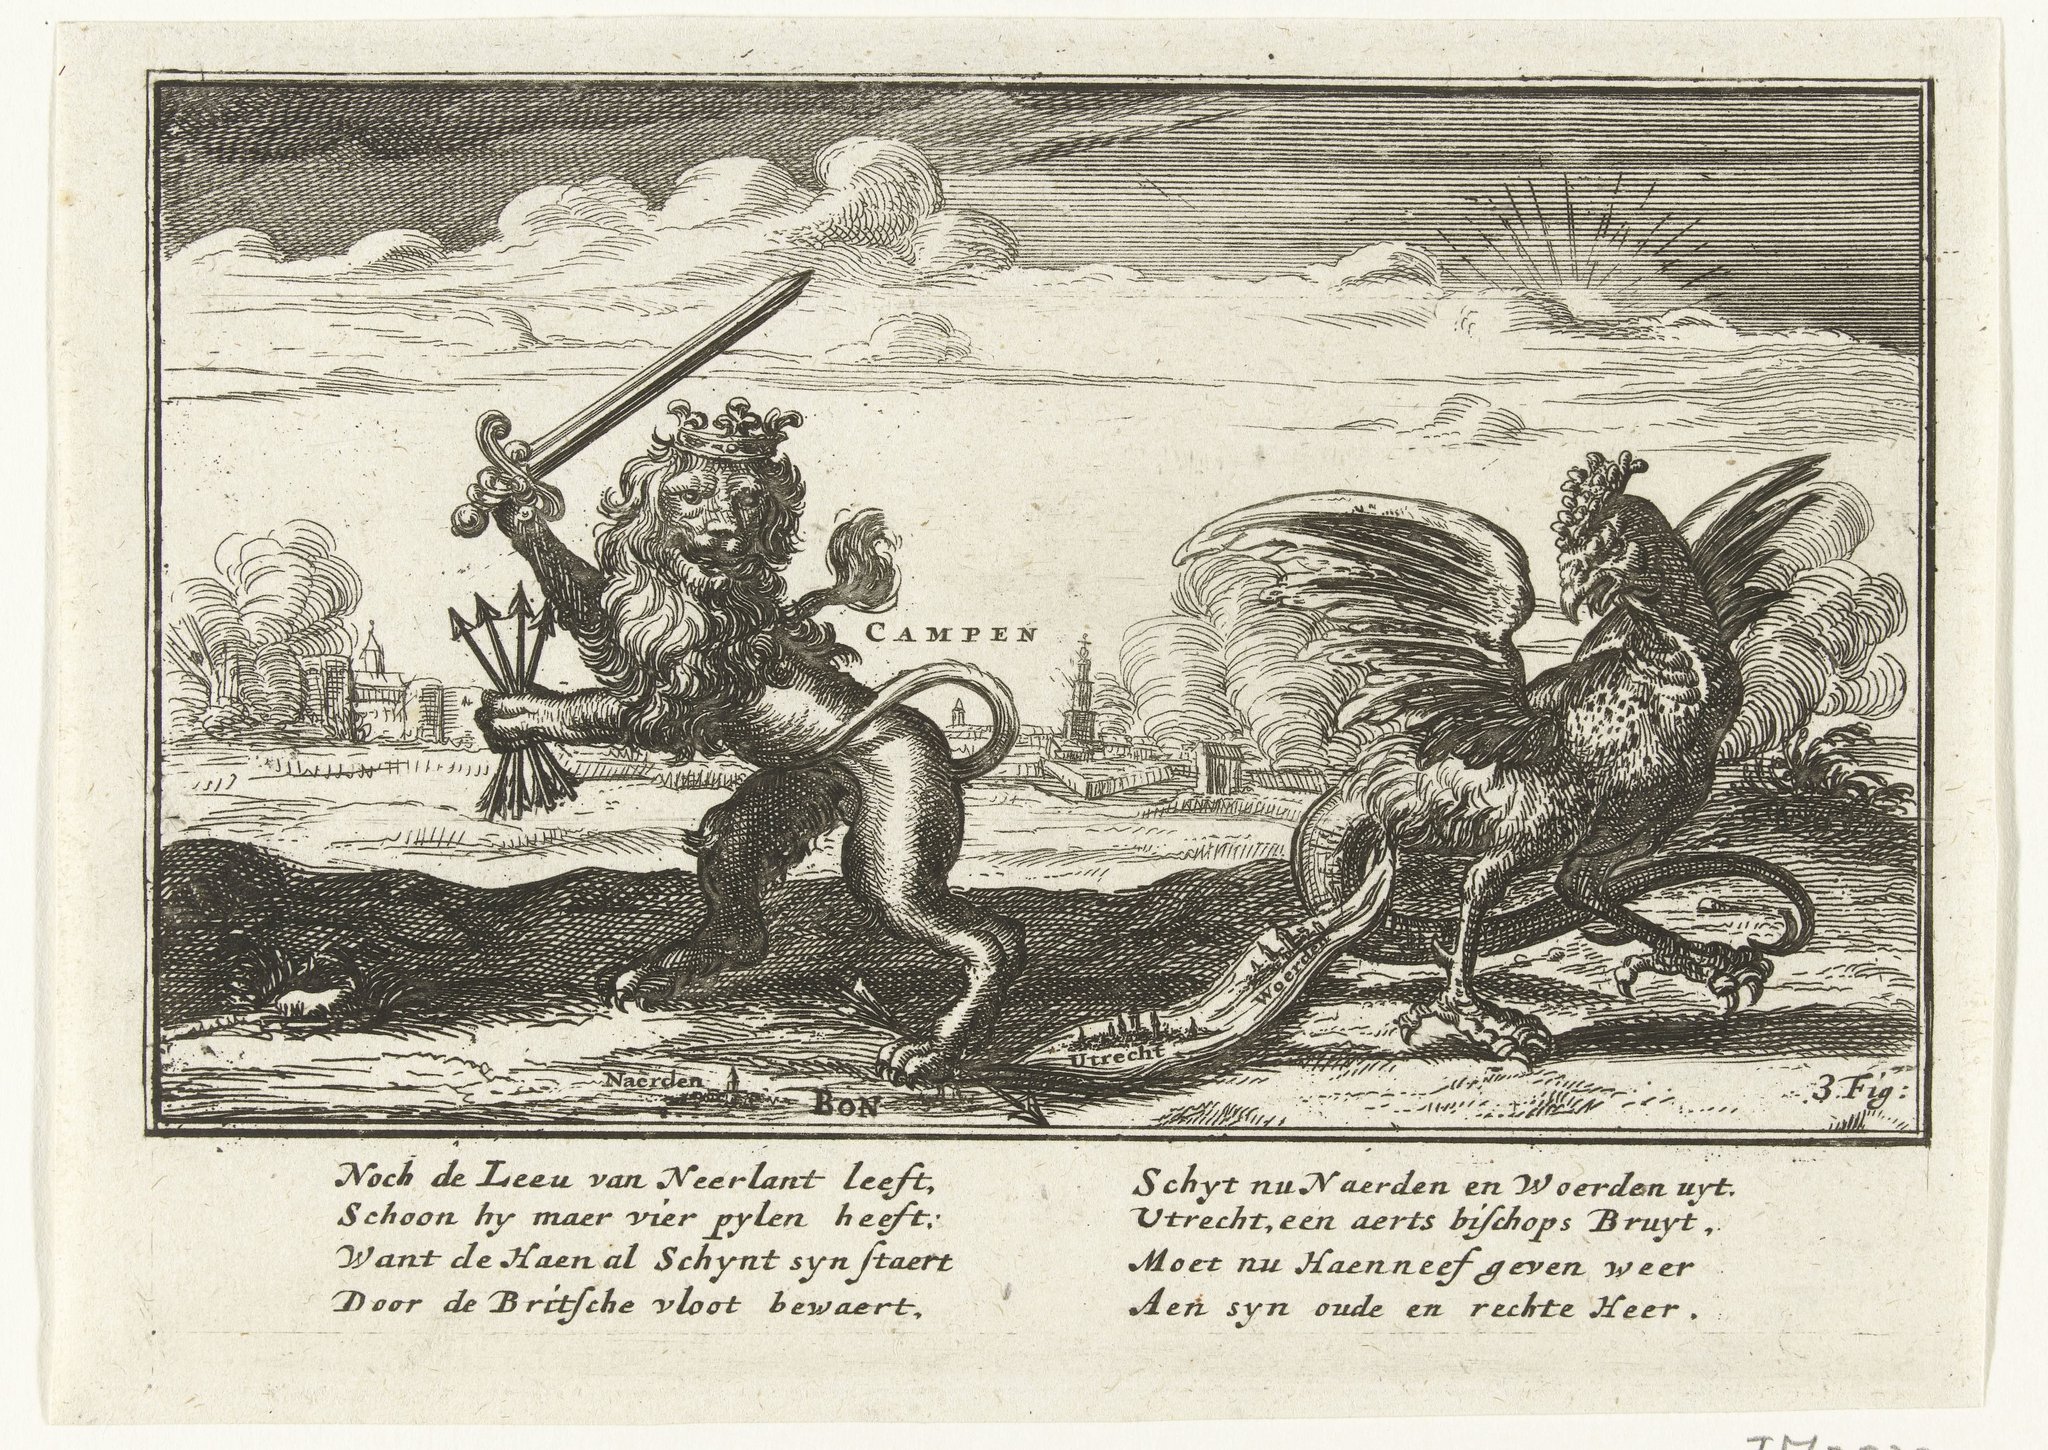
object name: cartoon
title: De Hollandse Leeuw verjaagt de Franse haan, 1672-1674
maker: Anonymous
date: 1674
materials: paper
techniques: engraving, etching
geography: northern netherlands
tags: rampjaar (disaster year)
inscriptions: date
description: De Hollandse Leeuw verjaagt de Franse haan met drakenstaart. Uit het achterste van de haan loopt een stroom met de namen van heroverde steden Utrecht, Woerden, Naarden en Bonn. Op de achtergrond Kampen. Met onderschrift van 2 verzen van 4 regels. Prent nr. 3 in een serie van zes allegorieën op de oorlog met Frankrijk en de Duitse bisschoppen in de jaren 1672-1674, ontleend aan de oratie van professor L. Wolfogen over zijn droom en de uitleg daarvan gedaan op de Hogeschool te Amsterdam op 11 januari 1674.